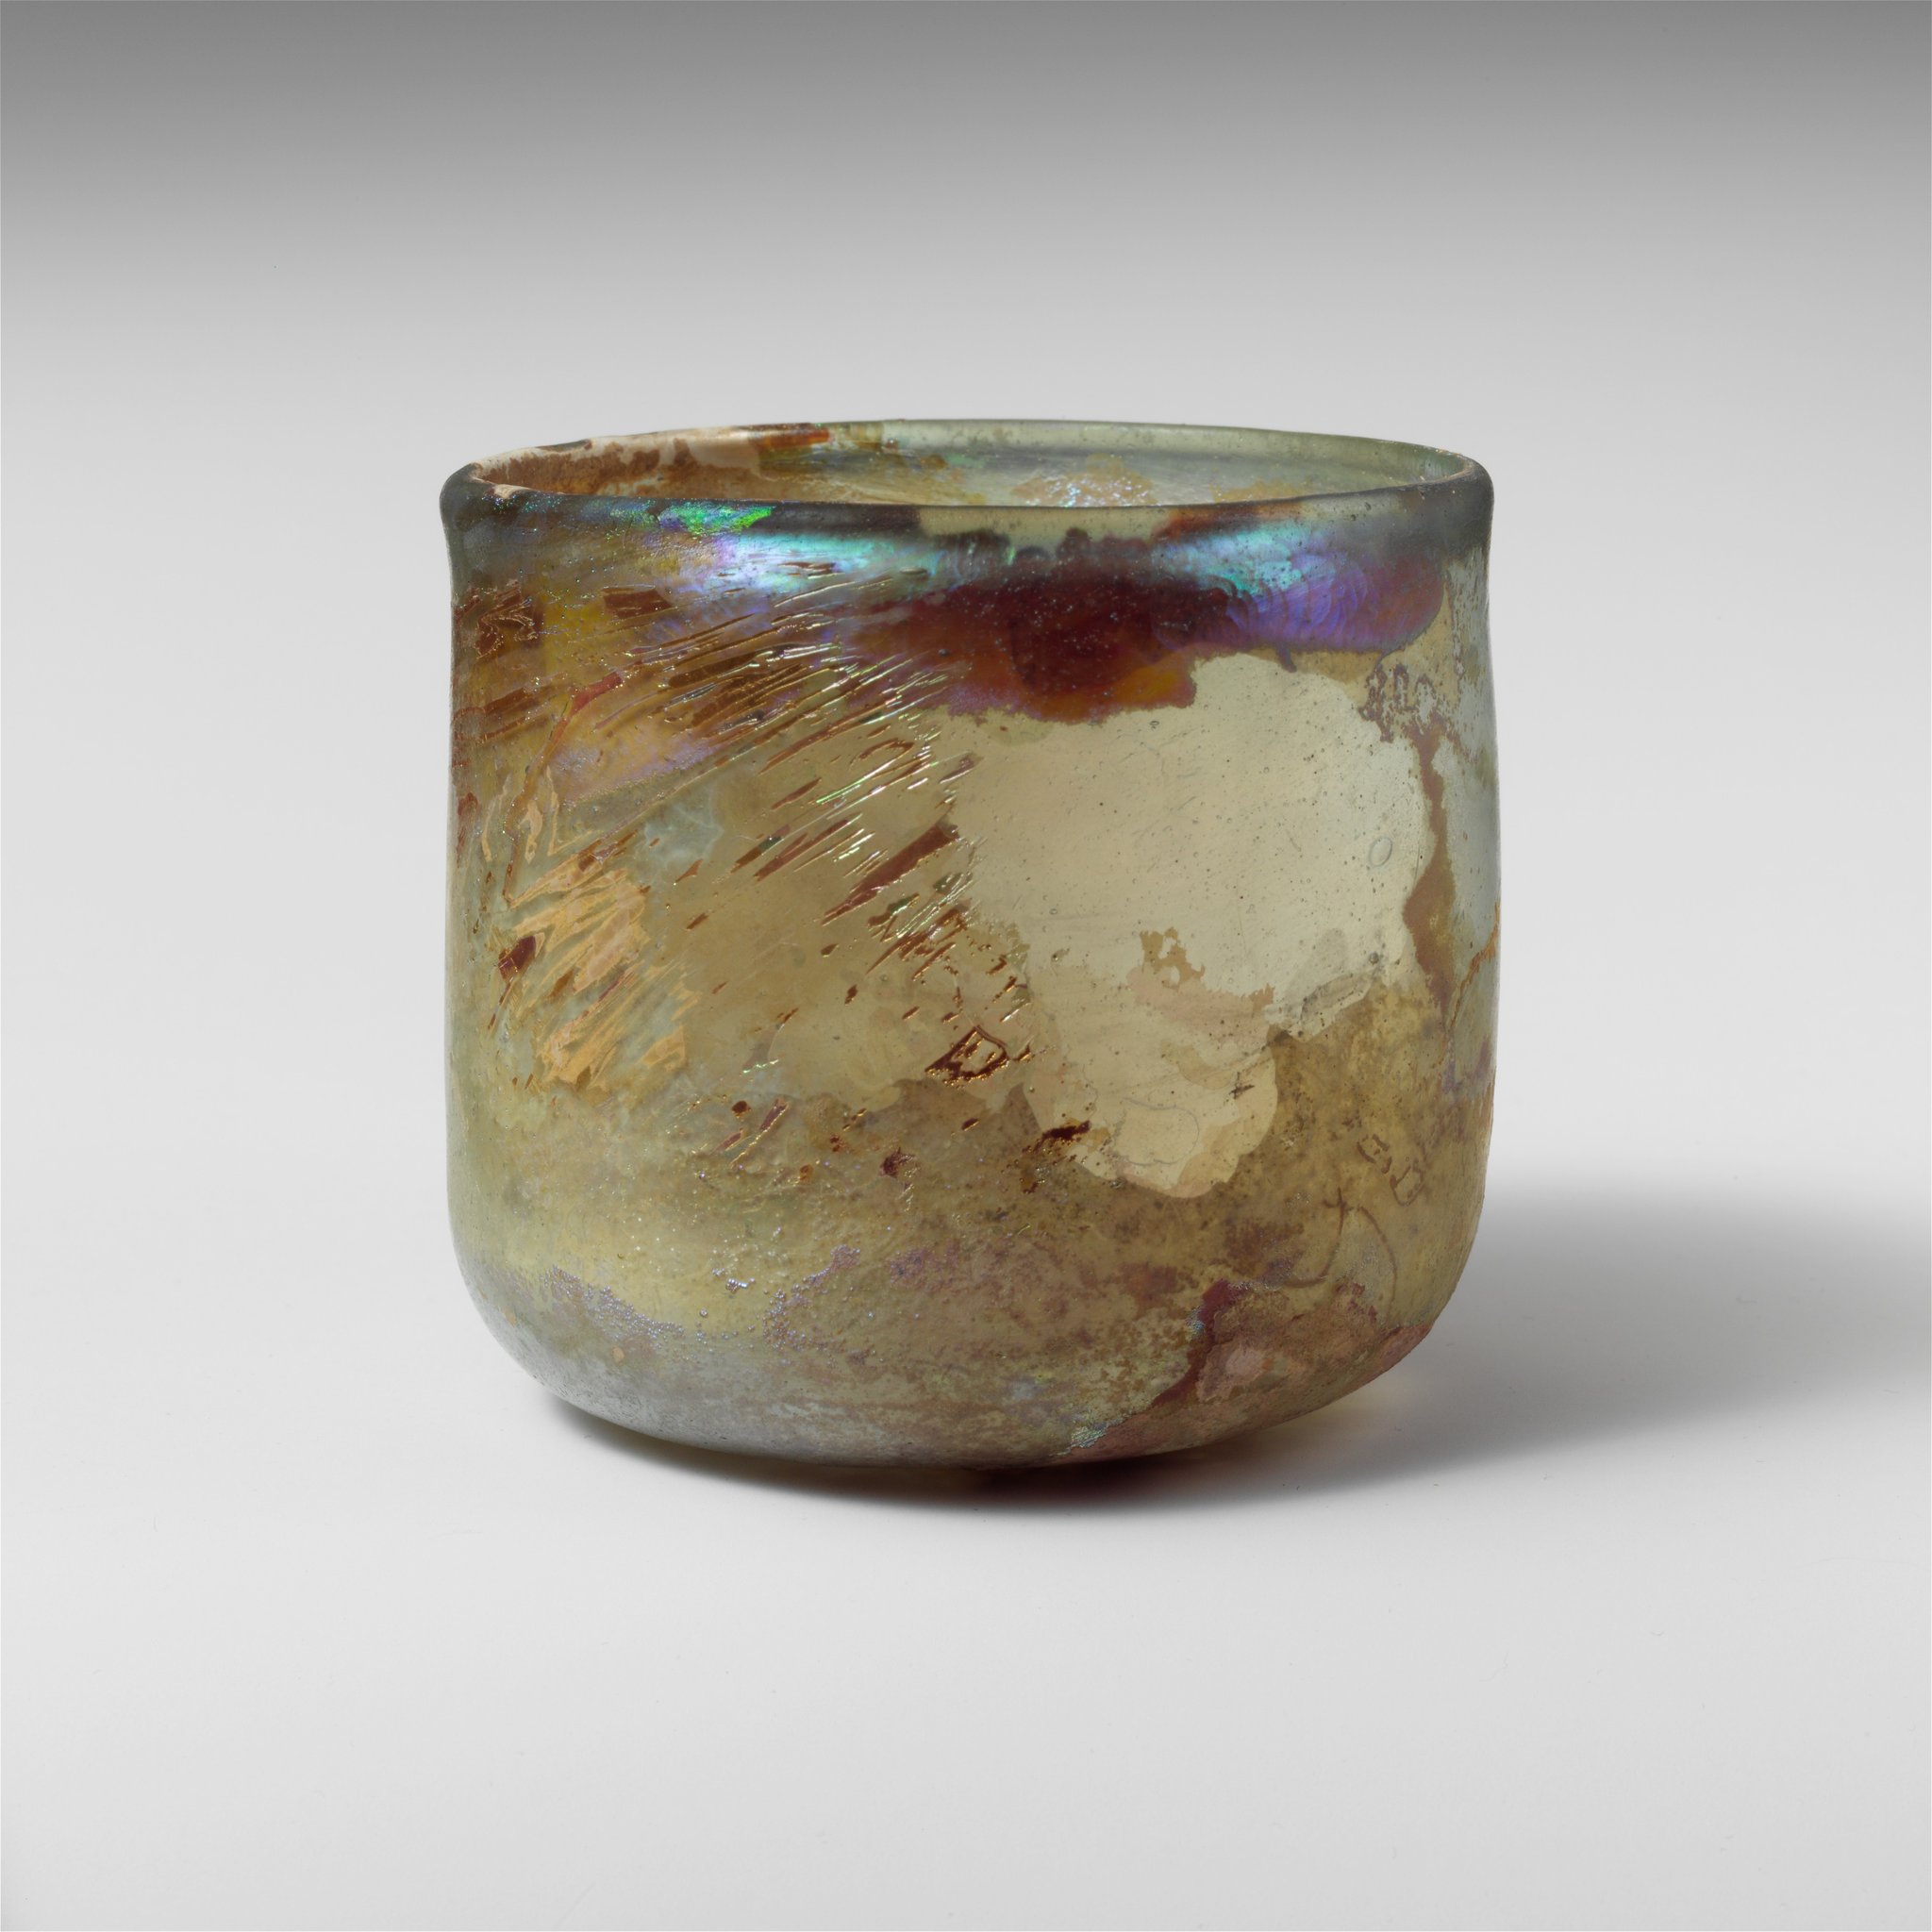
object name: cup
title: Glass beaker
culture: roman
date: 101-300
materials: glass